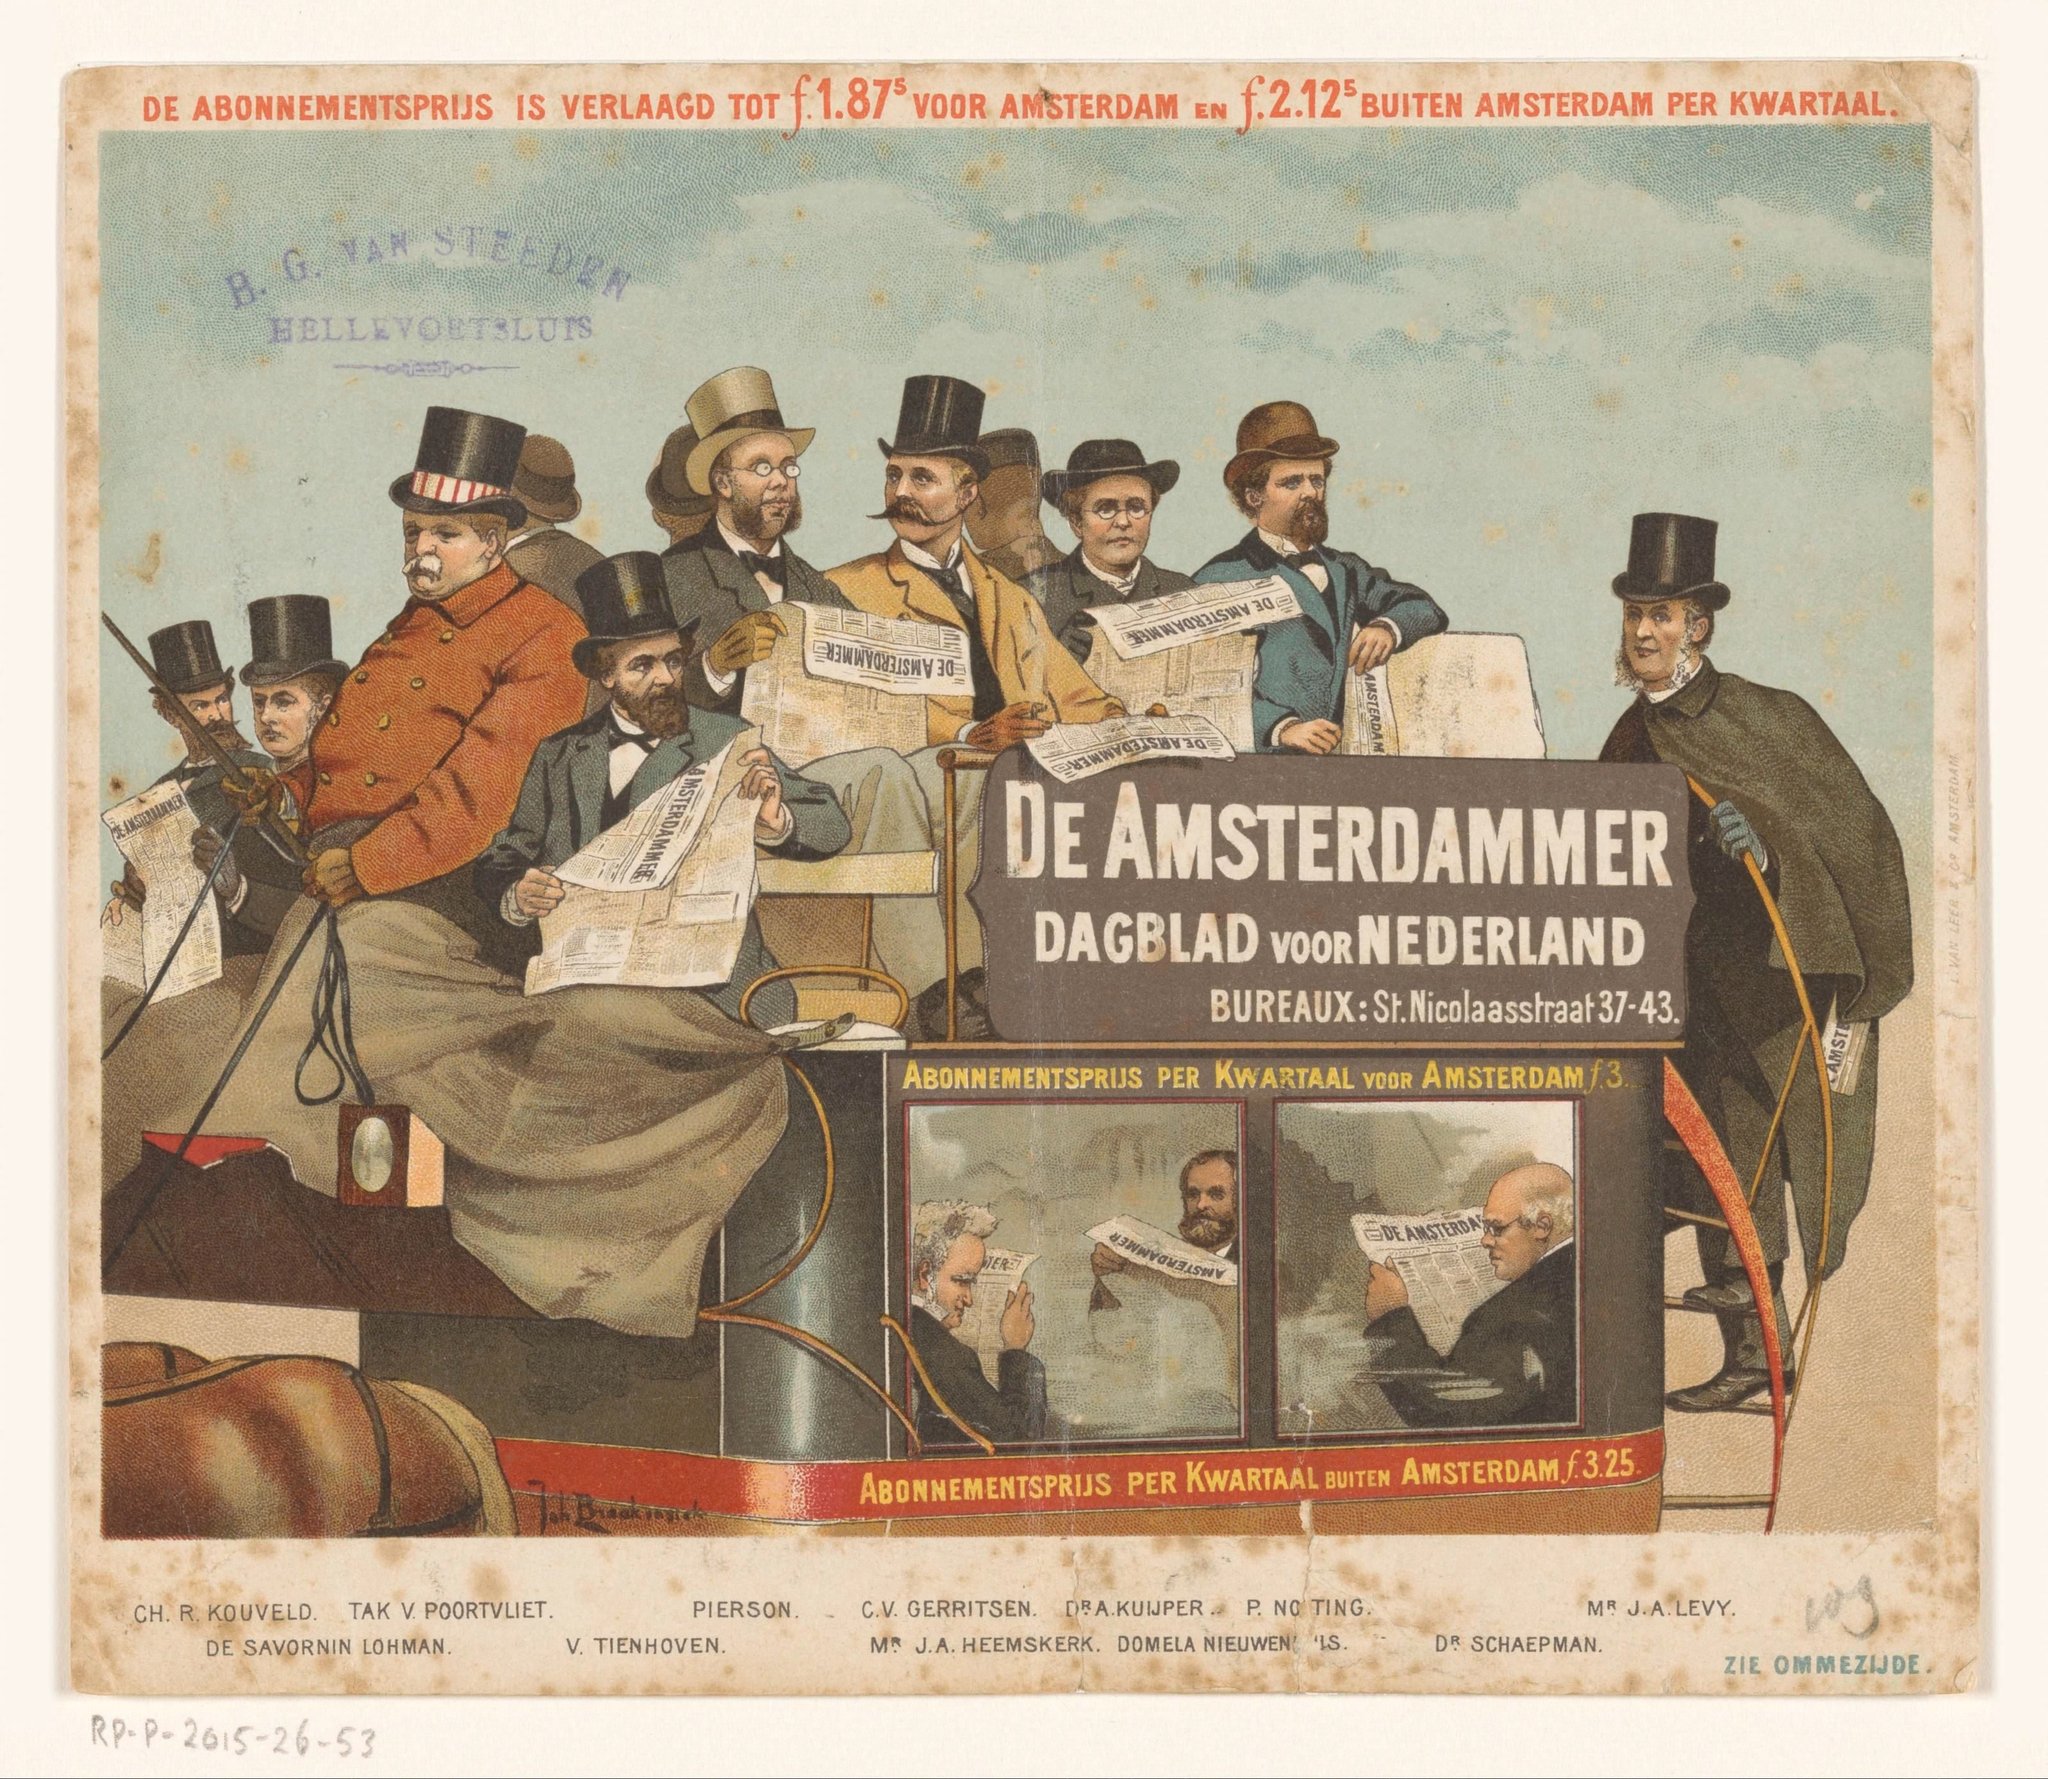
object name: print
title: De Amsterdammer. Dagblad voor Nederland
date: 1880-1886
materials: cardboard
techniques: lithograph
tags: mayor, gijsbert van tienhoven, the hague, jonkheer alexander frederik de savornin lohman, abraham kuyper, rome, priest, herman johannes aloysius maria schaepman, politician, ferdinand domela nieuwenhuis, amsterdam, allard pierson, diligence, omnibus, horse-tram, newspaper, news-sheet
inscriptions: collector's mark: ‘H.G. van Steeden Hellevoetsluis’, collector's mark: Lugt 2228, collector's mark: Lugt 4780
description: Op de voorzijde een paardentram met bekende Nederlanders, die op en in de tram De Amsterdammer lezen. Op de achterzijde advertenties.